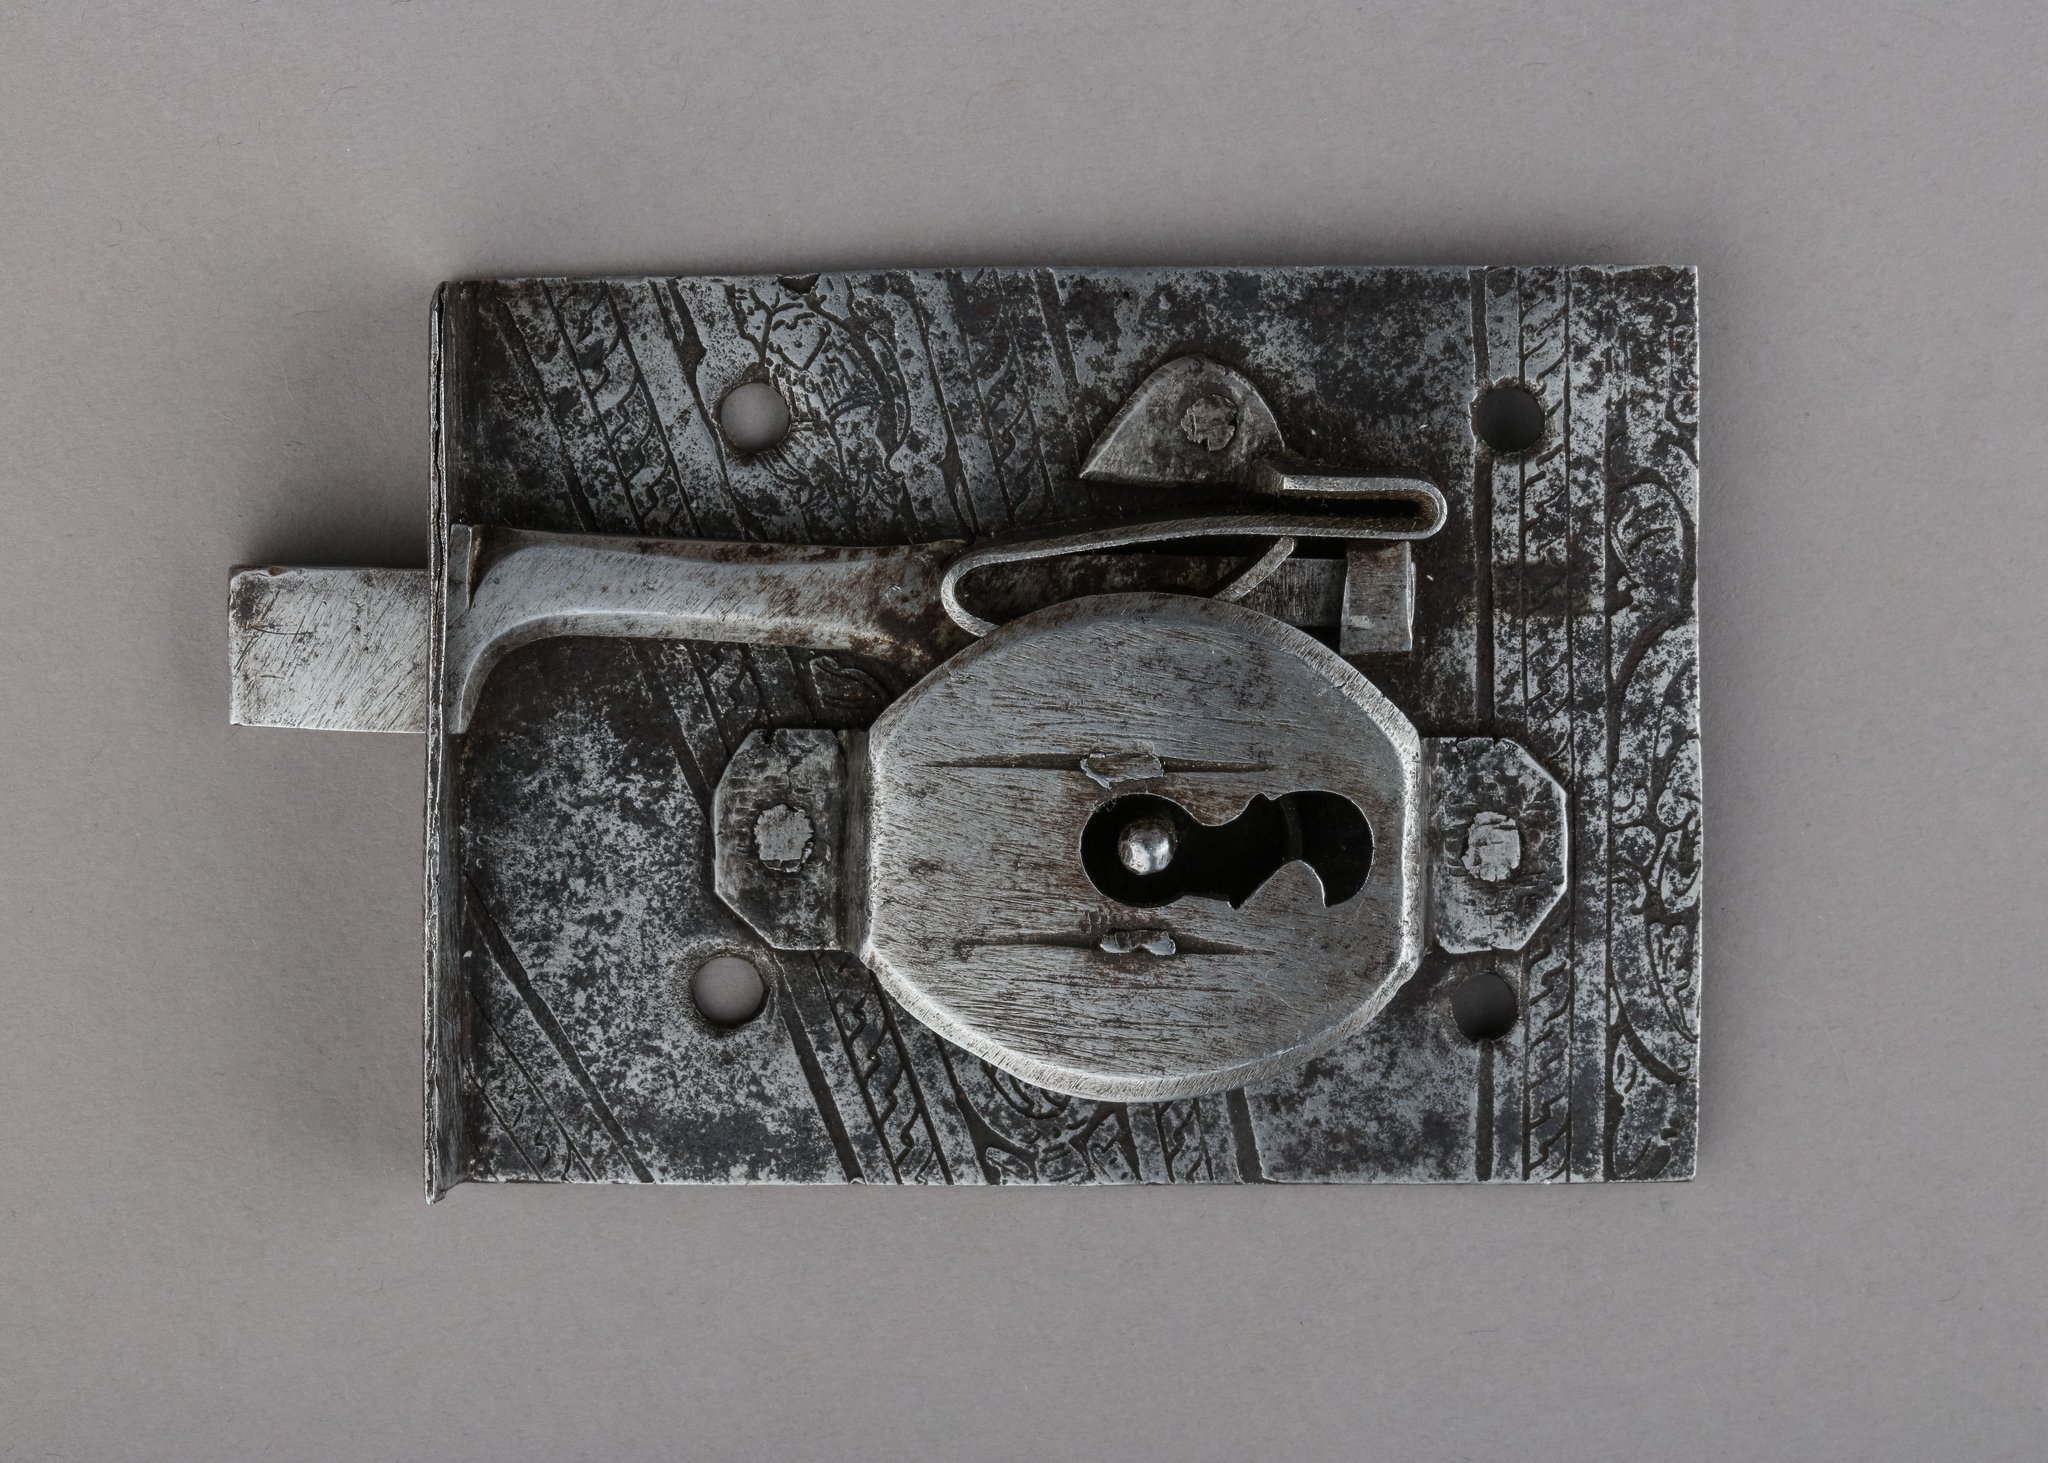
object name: rim lock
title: Lock, Rim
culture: spanish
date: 1570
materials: steel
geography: italy